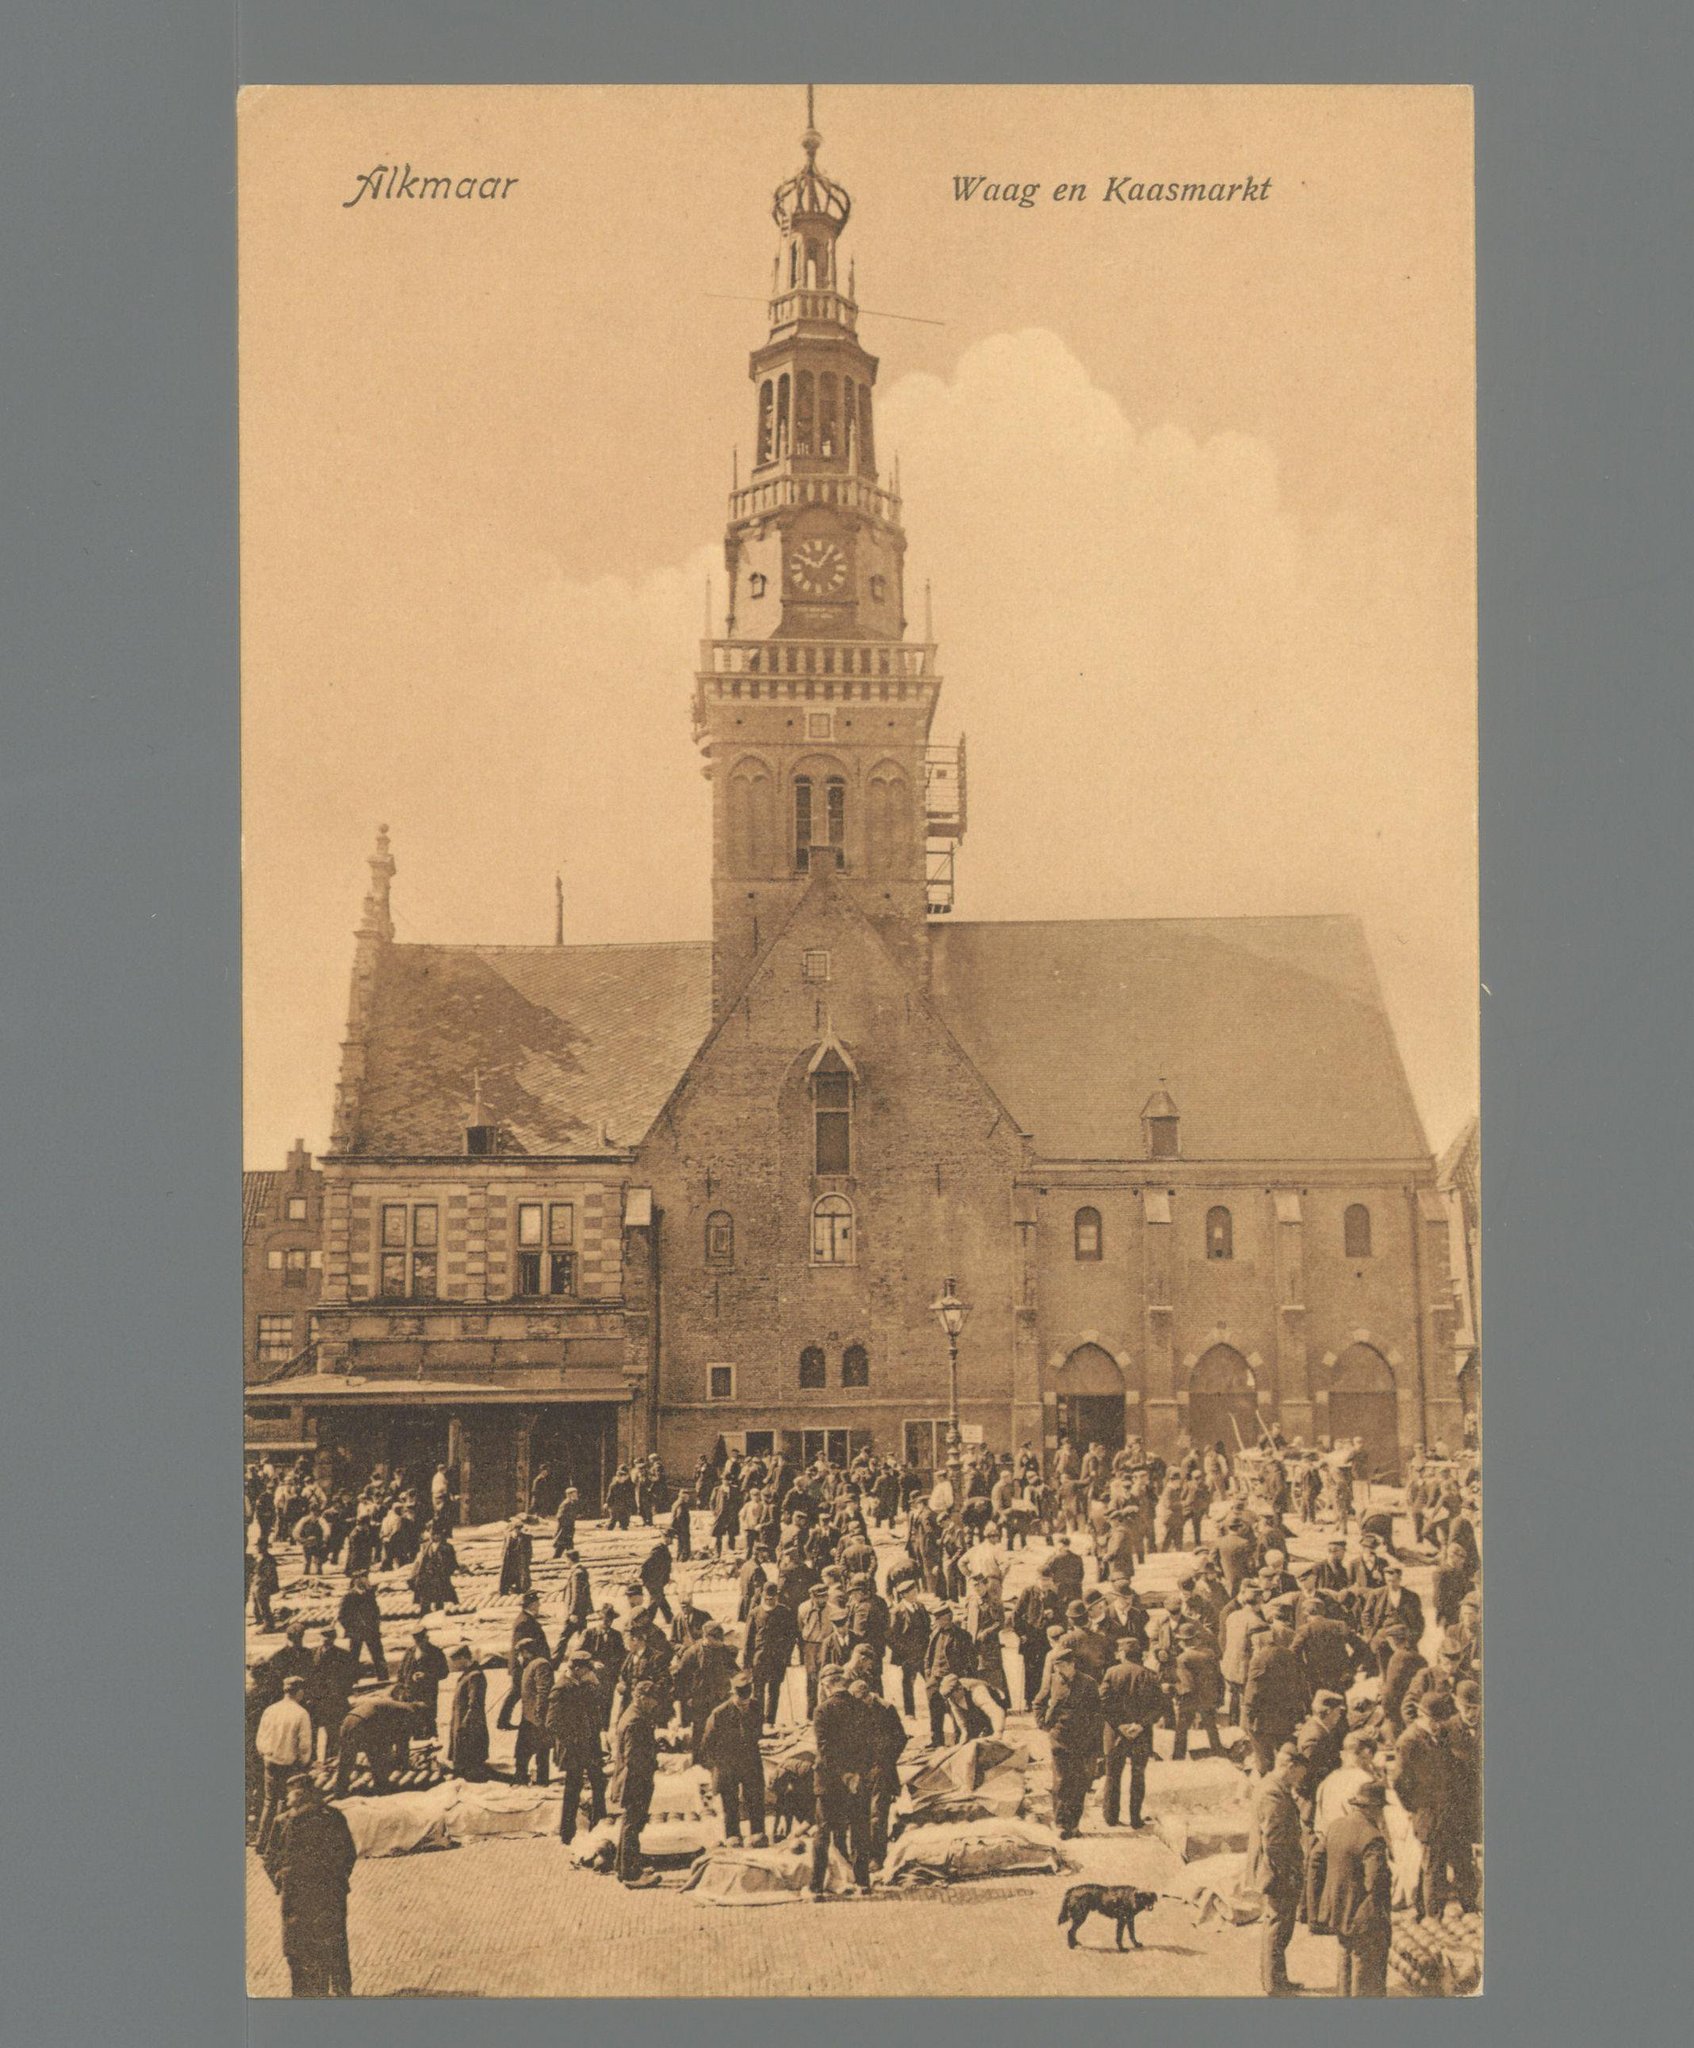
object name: photomechanical print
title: Alkmaar. Waag en Kaasmarkt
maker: Anonymous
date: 1909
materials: cardboard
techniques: photograph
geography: leipzig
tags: city-view, and landscape with man-made constructions, tower, clock tower ~ monumental adornment, market, cheese